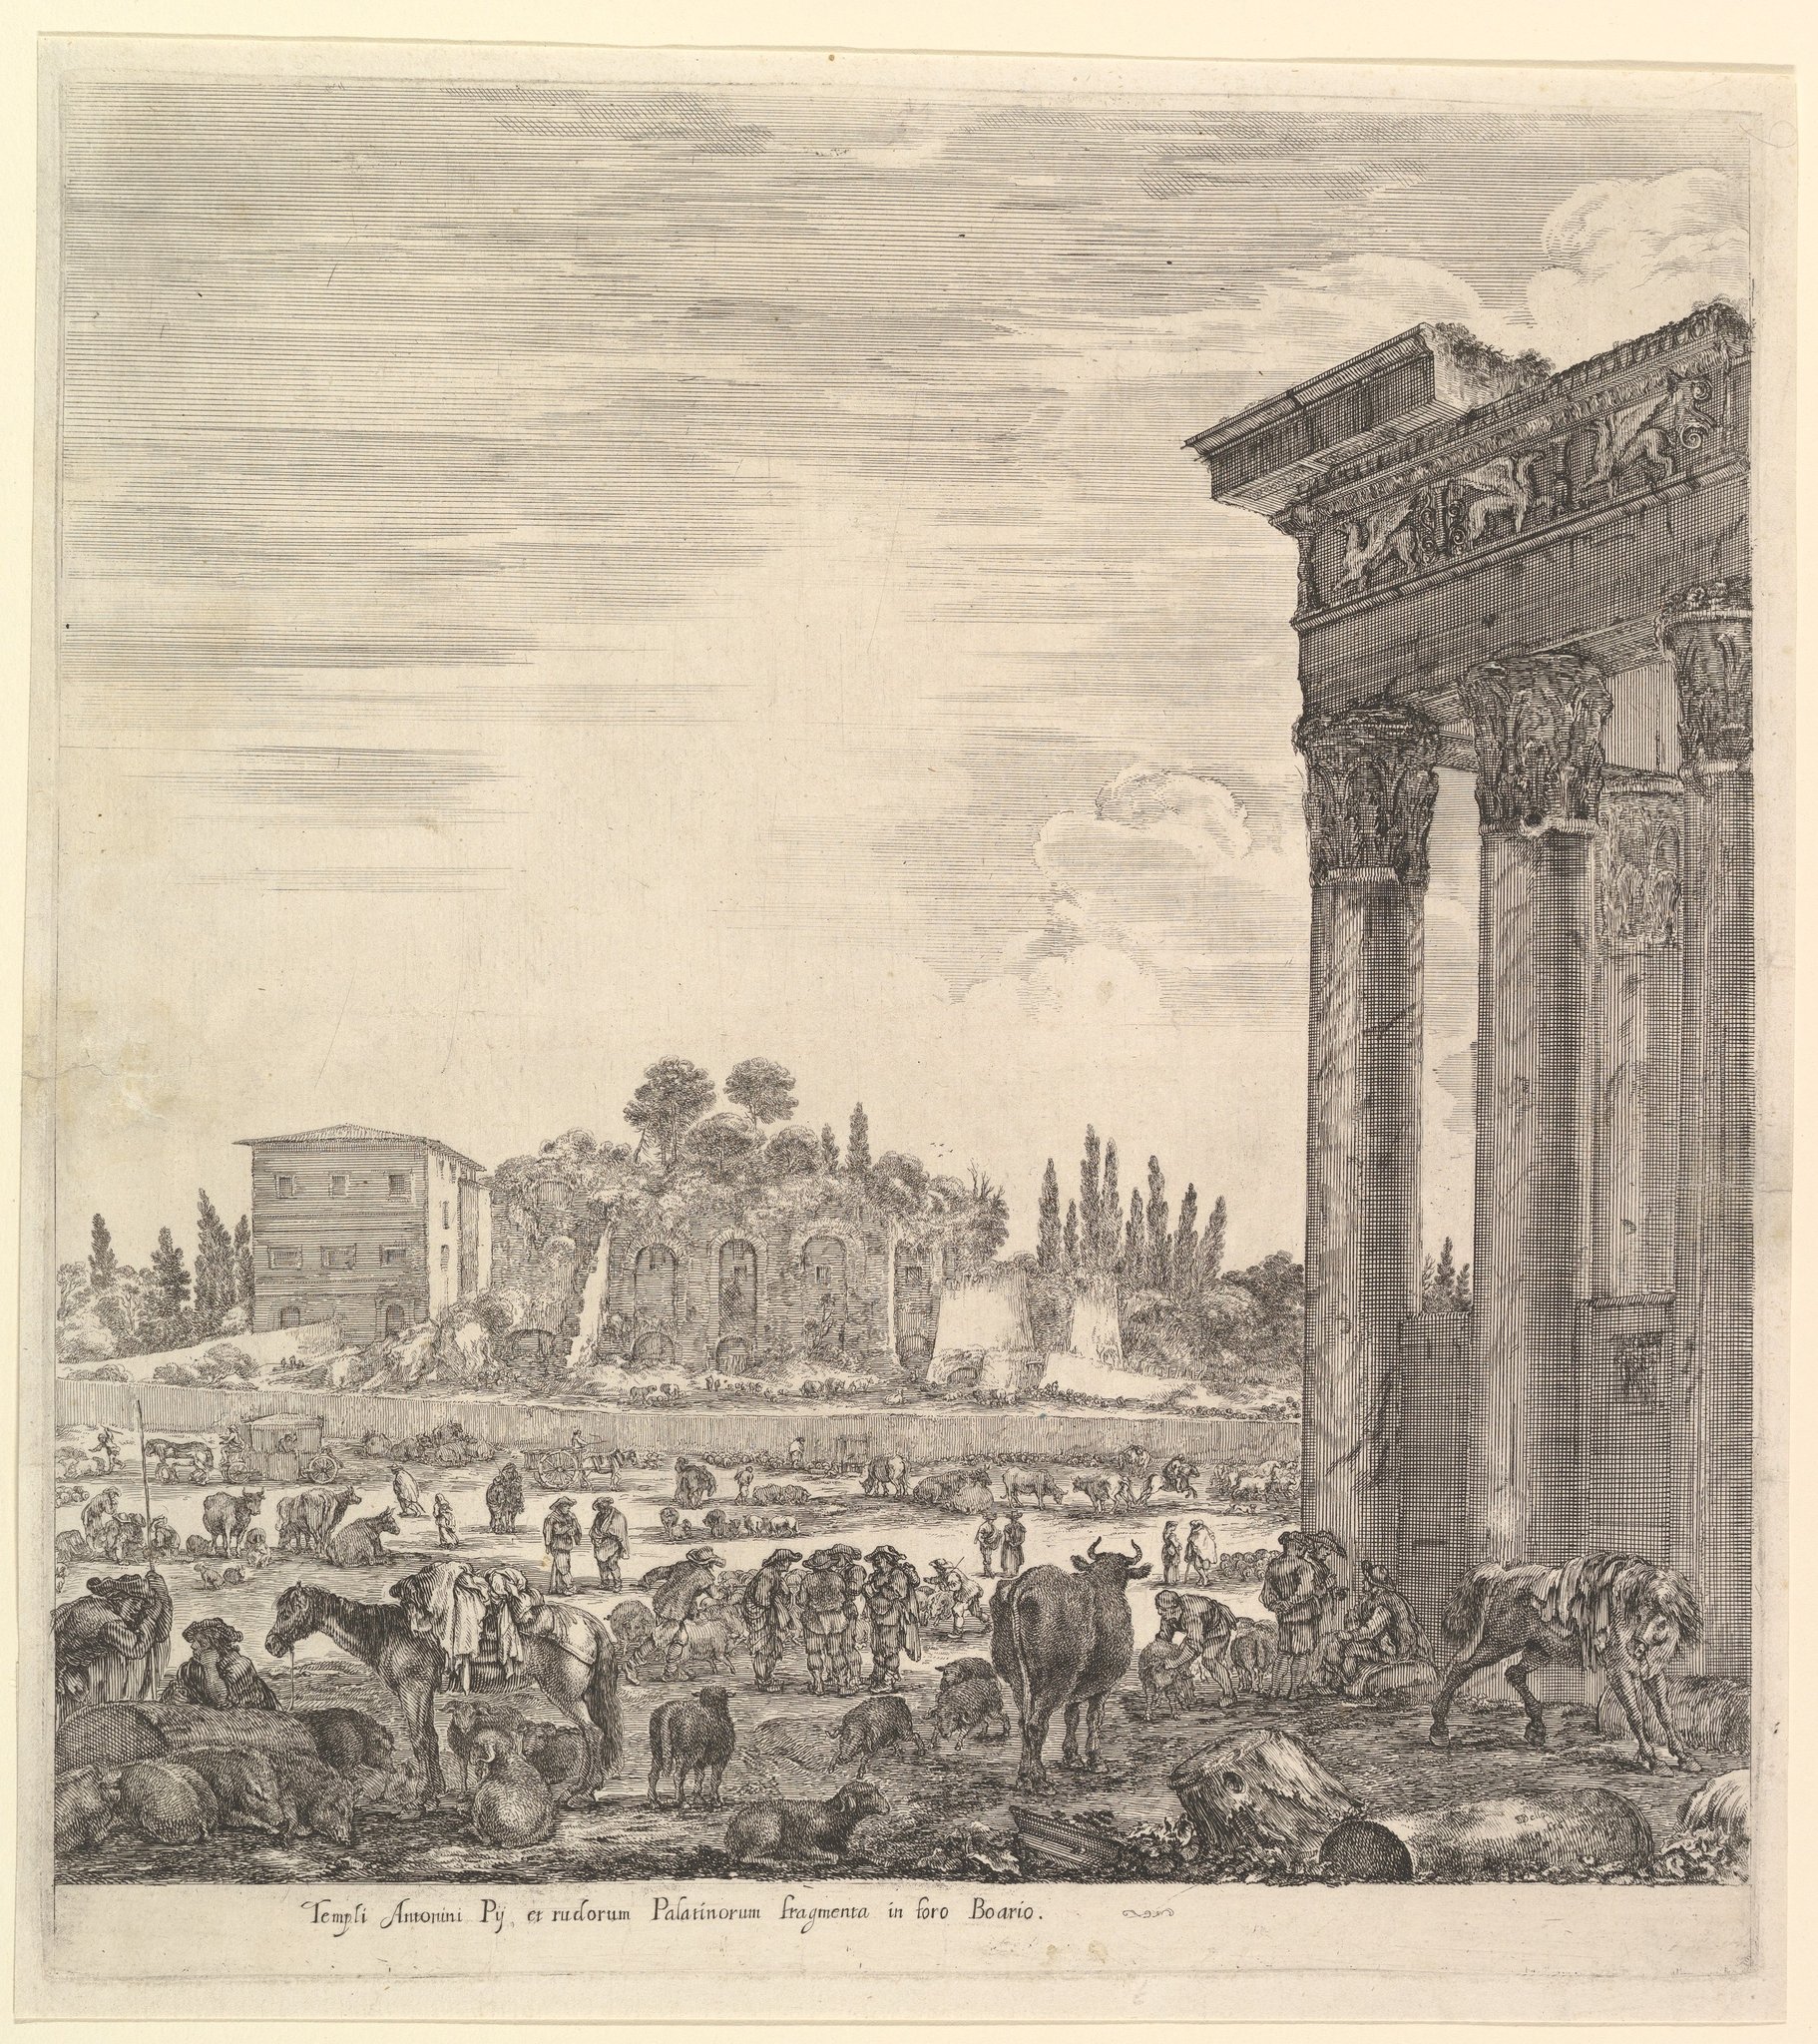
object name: print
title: The columns of the Temple of Antoninus to right, a part of the Campo Vaccino in center and at left, from "Six large views, four of Rome, and two of the Roman countryside" (Six grandes vues, dont quatre de Rome et deux de la Campagne romaine)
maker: stefano della bella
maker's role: artist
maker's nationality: italian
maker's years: 1610-1664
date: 1656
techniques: etching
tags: human figures,animals,columns,ruins